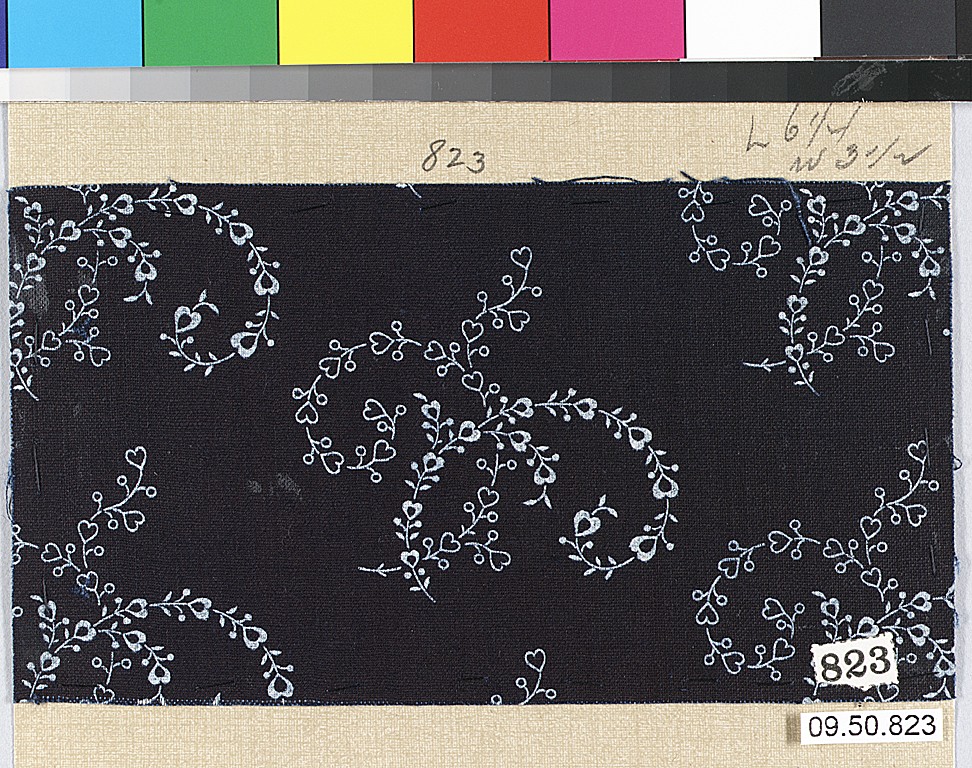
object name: piece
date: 1801-1900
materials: cotton